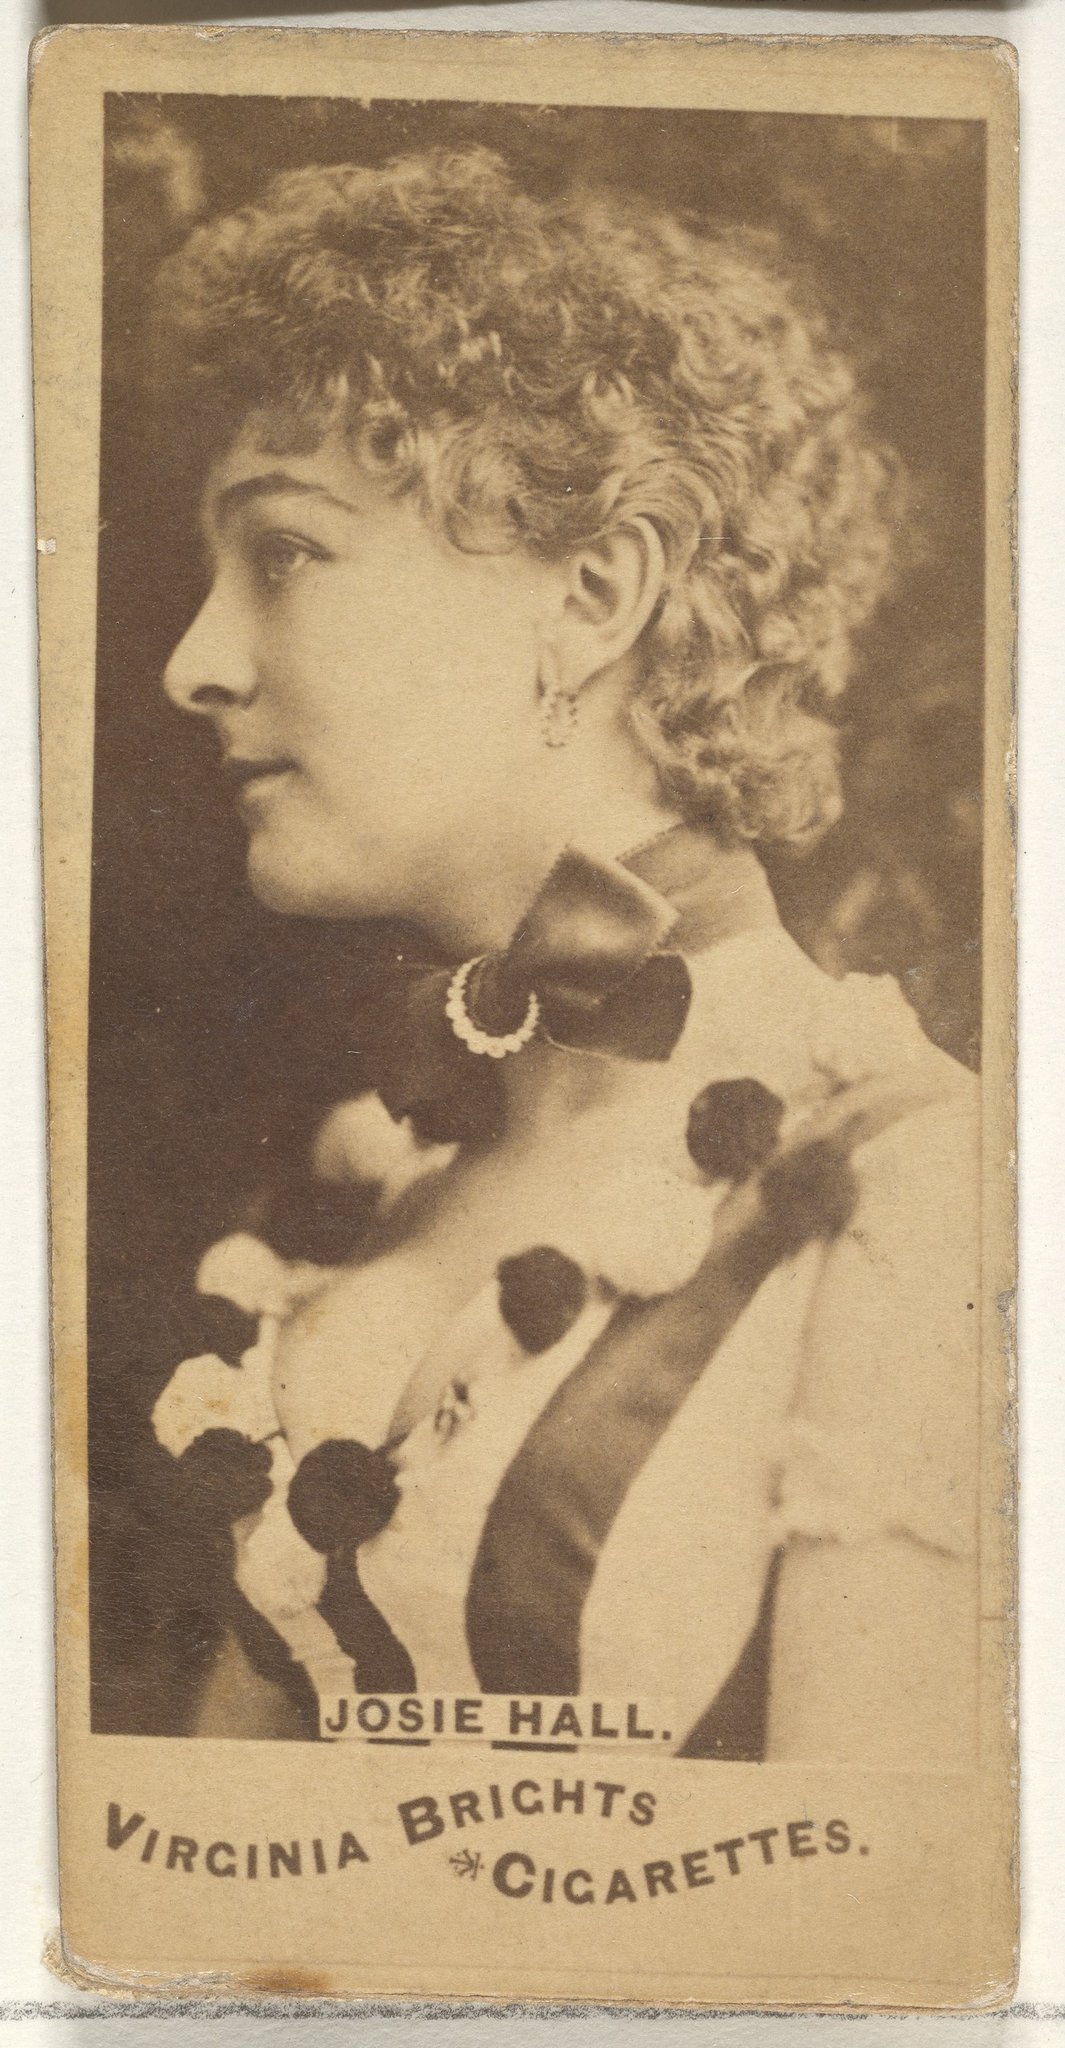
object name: photograph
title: Josie Hall, from the Actors and Actresses series (N45, Type 1) for Virginia Brights Cigarettes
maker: allen & ginter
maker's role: publisher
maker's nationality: american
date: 1888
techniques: albumen silver print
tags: portraits,profiles,women,actresses